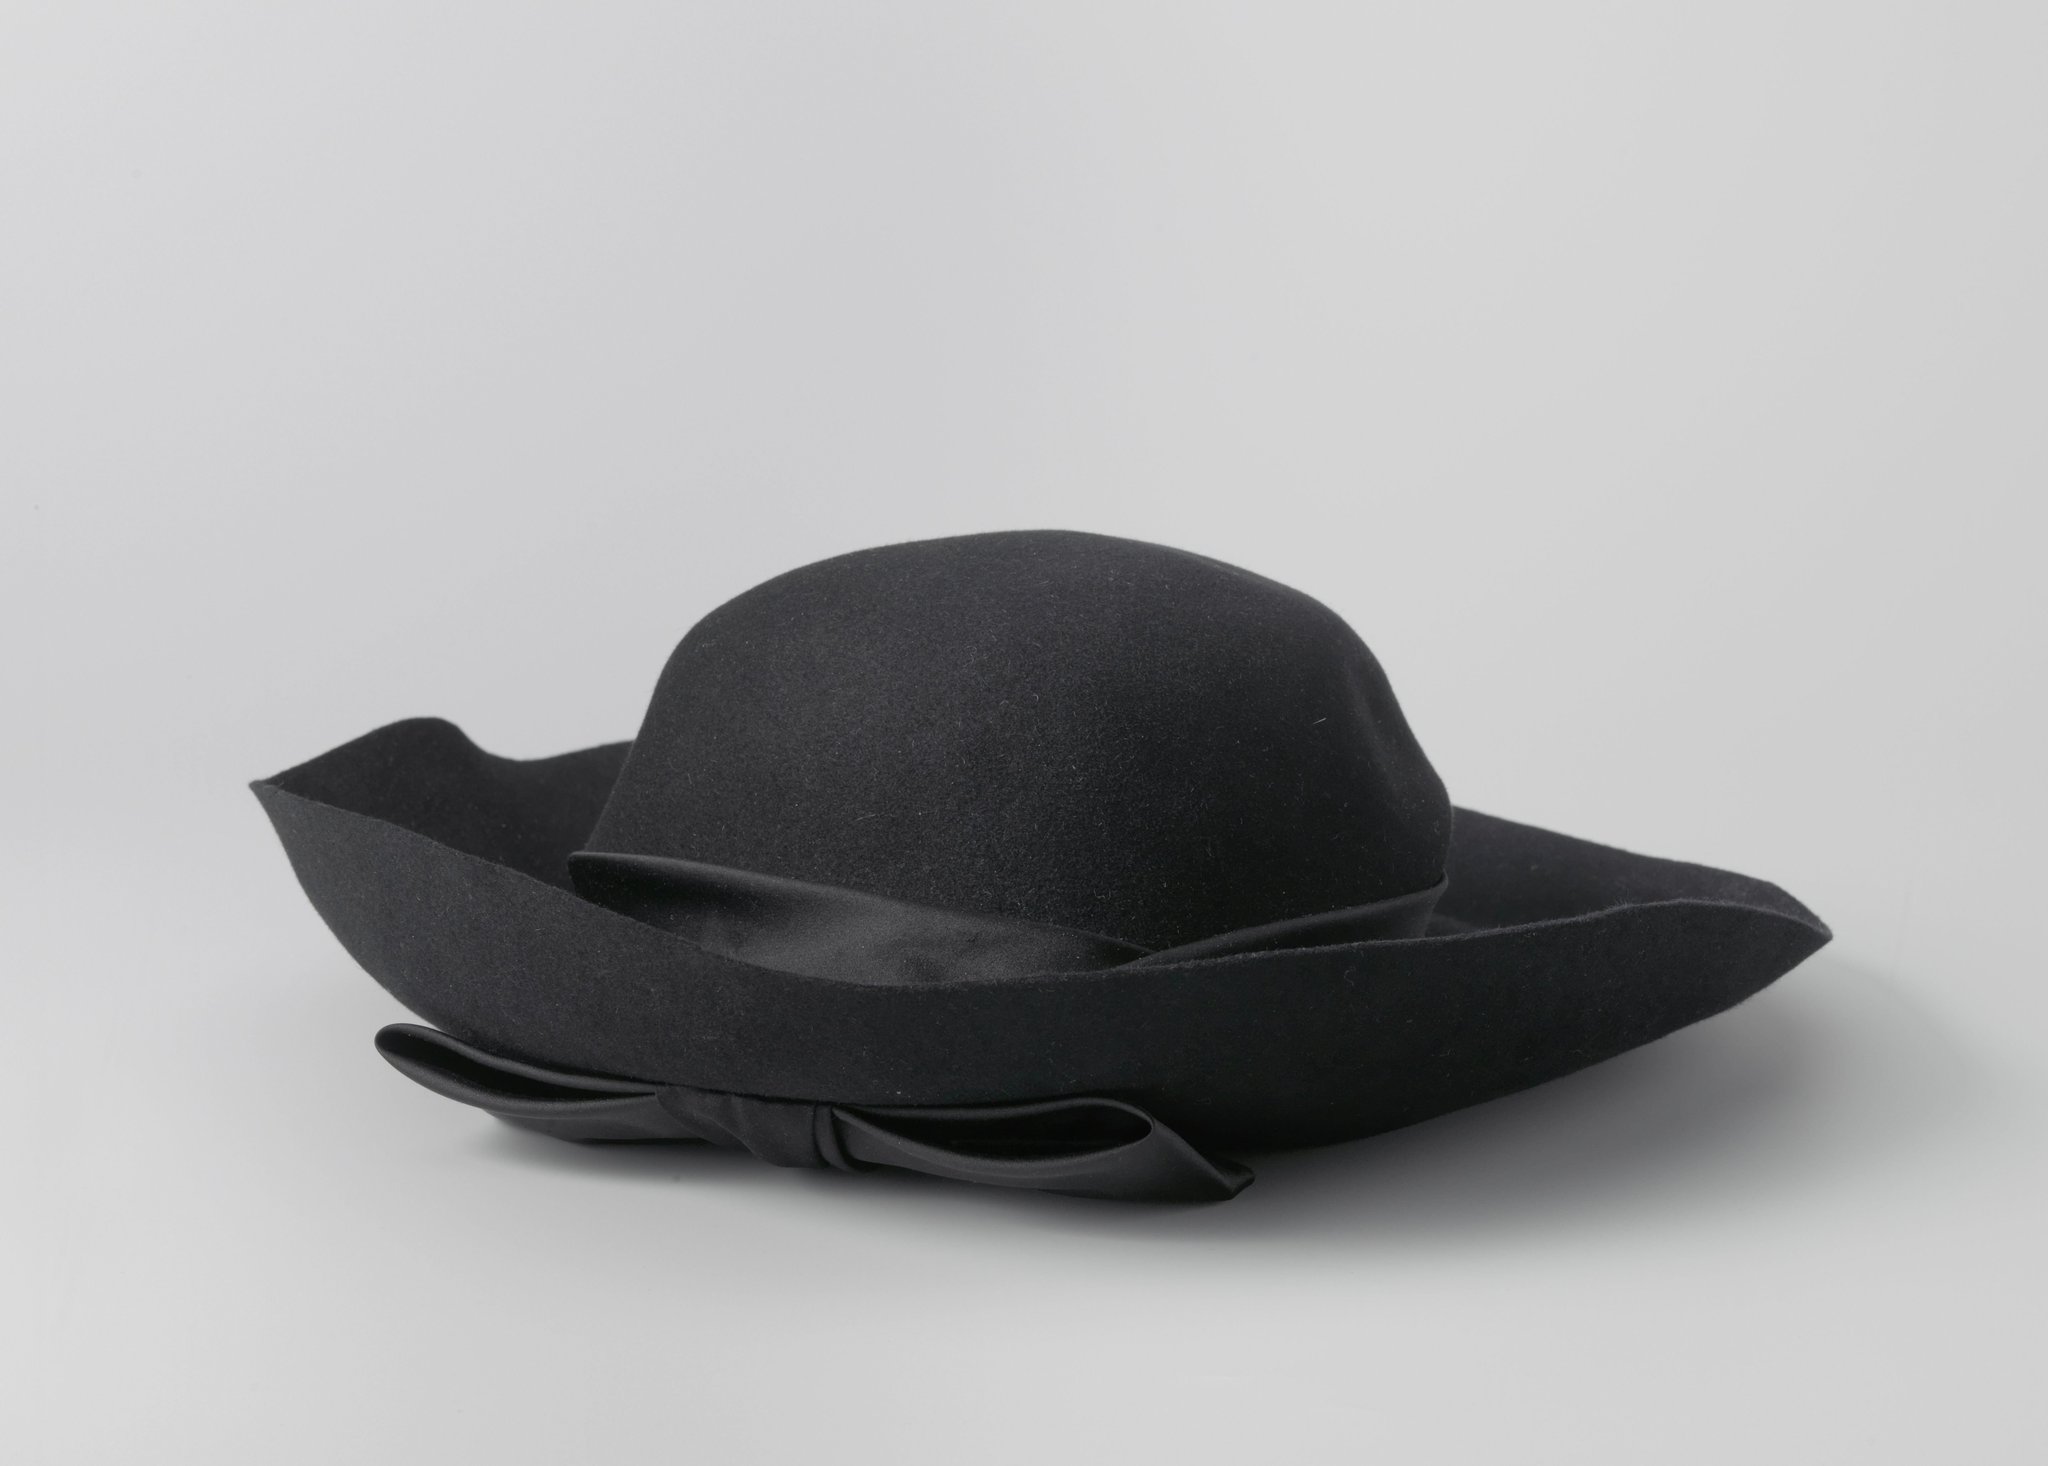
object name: hat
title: Hoed van zwart vilt met satijnen band om bol, die middenvoor eindigt in een platte strik met bijpassende hoedenspeld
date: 1960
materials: felt, textile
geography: amsterdam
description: Hoed van zwart vilt met satijnen band om bol, die middenvoor eindigt in een platte strik met bijpassende hoedepen, wordt als een zuidwester gedragen. La Femme Chic, Amsterdam.